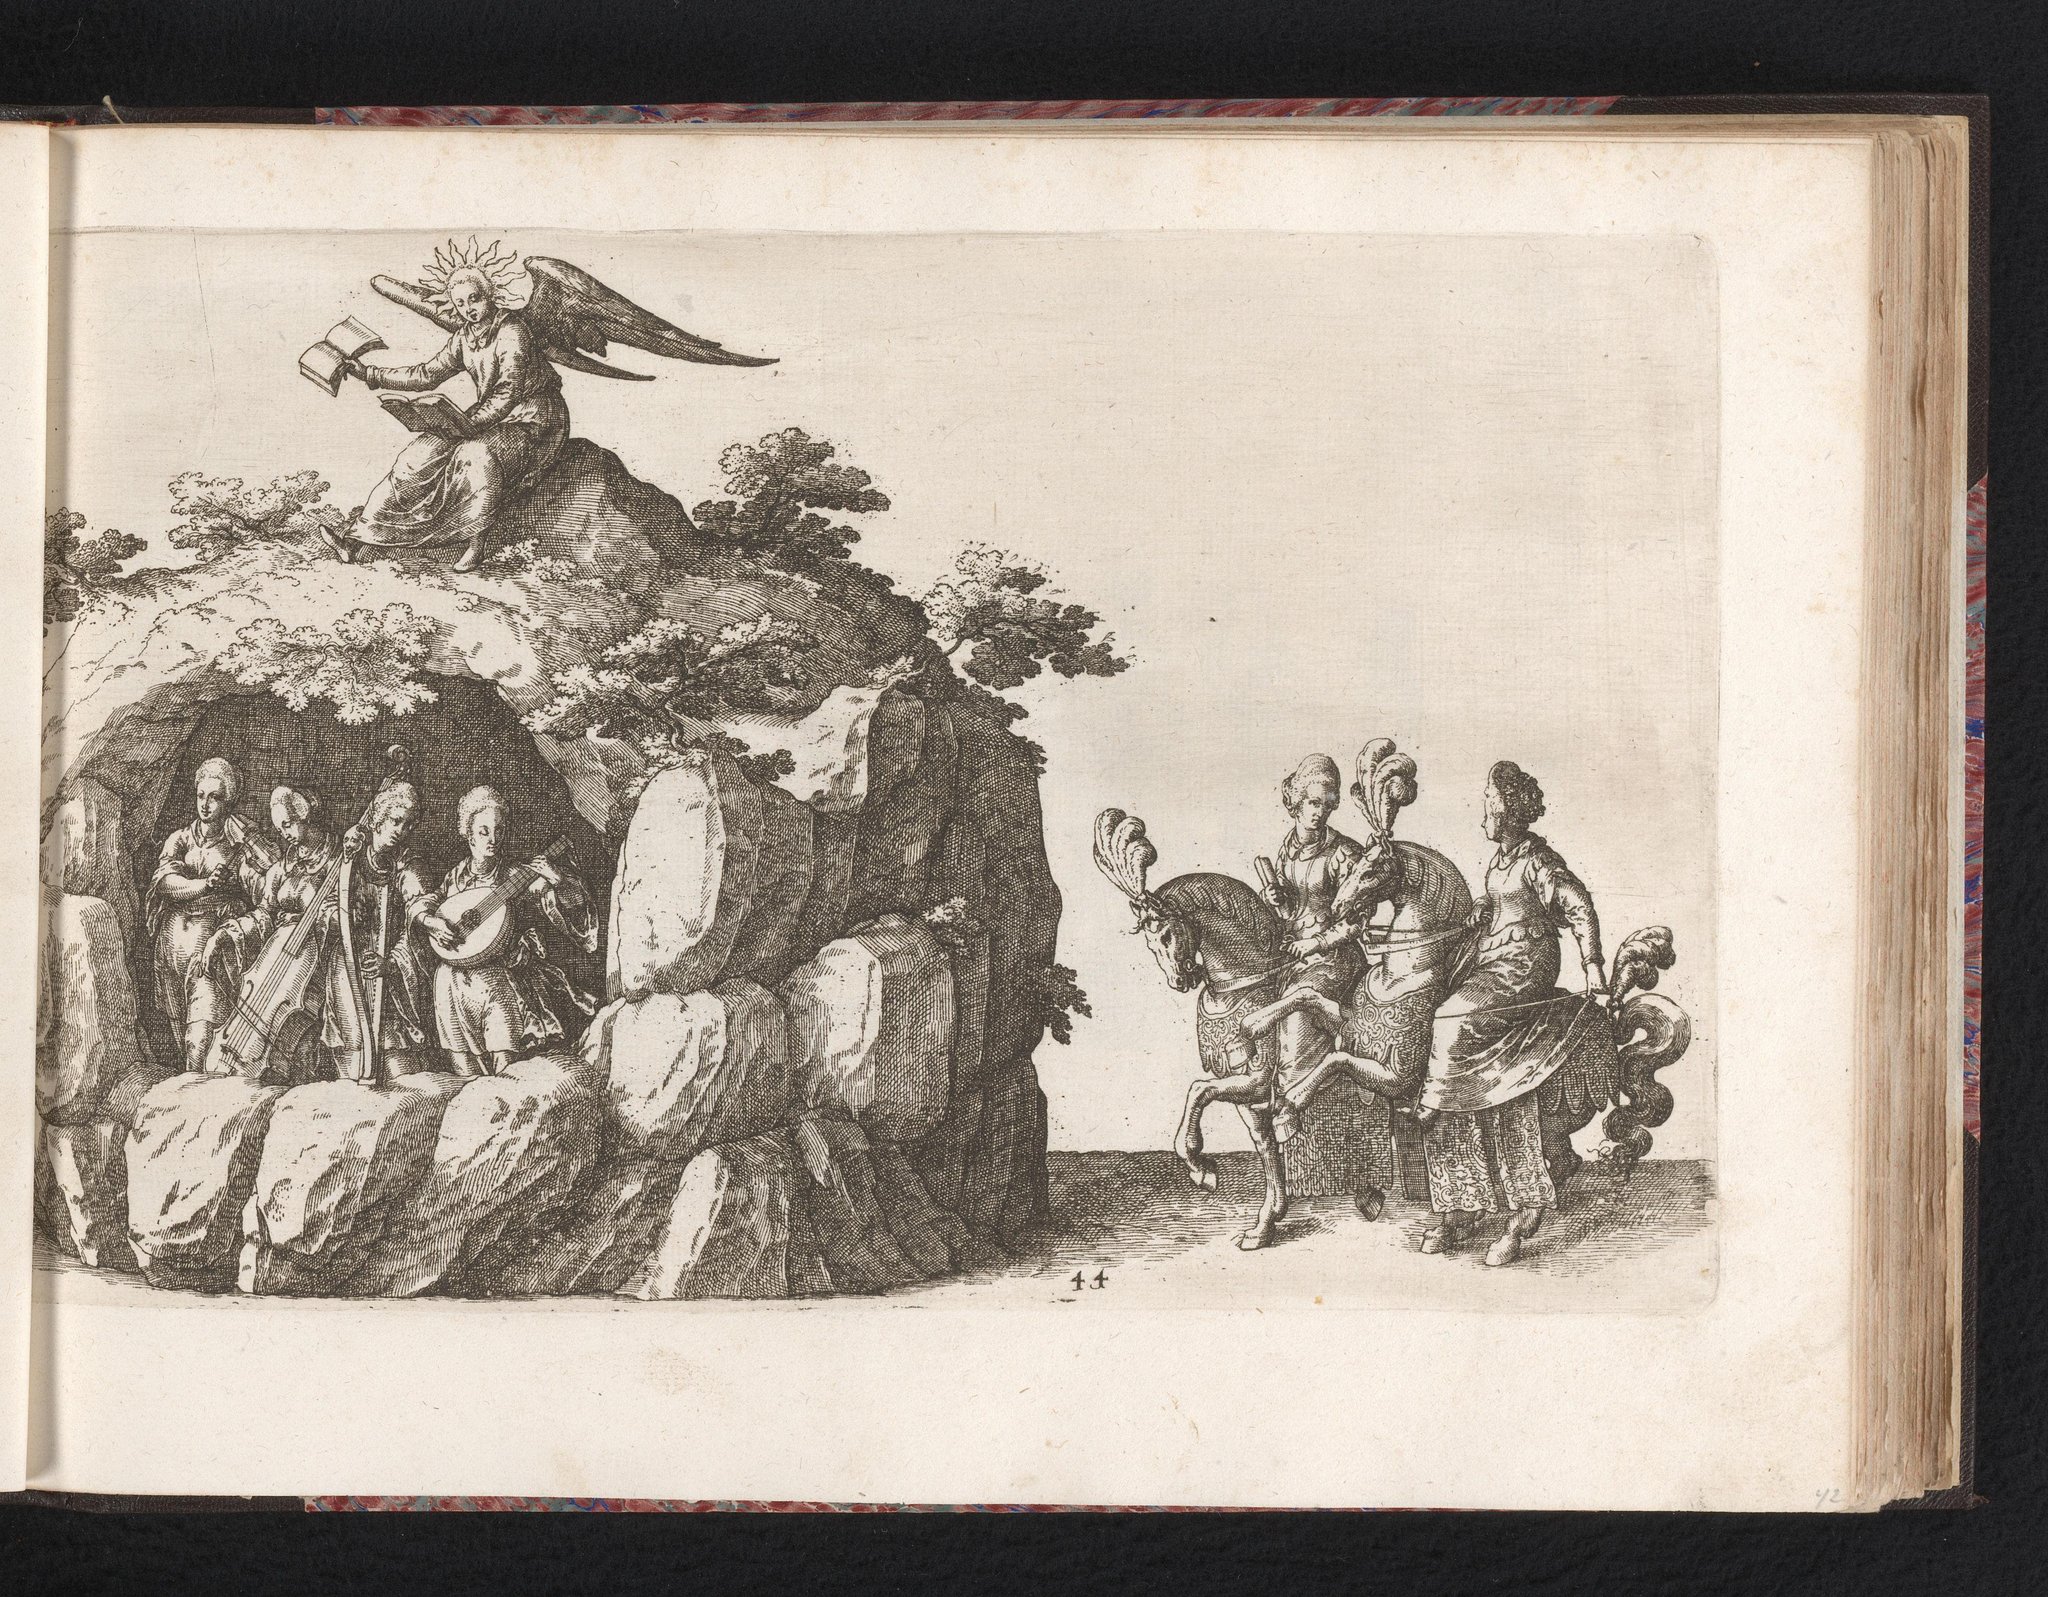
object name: print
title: Aigentliche wahrhaffte Delineation unnd Abbildung aller fürstlichen Auffzüg und Rütterspilen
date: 1618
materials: paper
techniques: etching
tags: monsters of mixed human and animal shape; 'mostri' (ripa), 'laub- und bandelwerk' ~ ornament, mask, mascaron ~ ornament, flowers ~ ornament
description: Genummerd: 43. Deze prent maakt deel uit van een album.